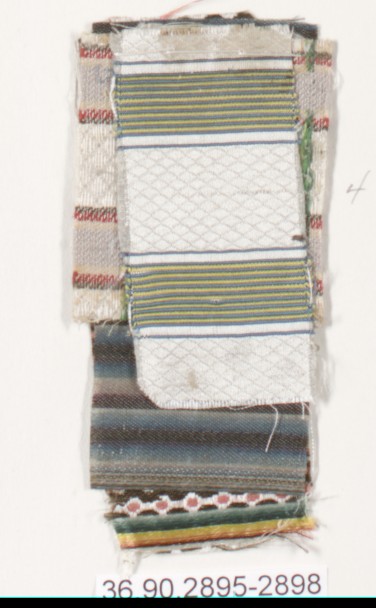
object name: piece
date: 1801-1900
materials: silk